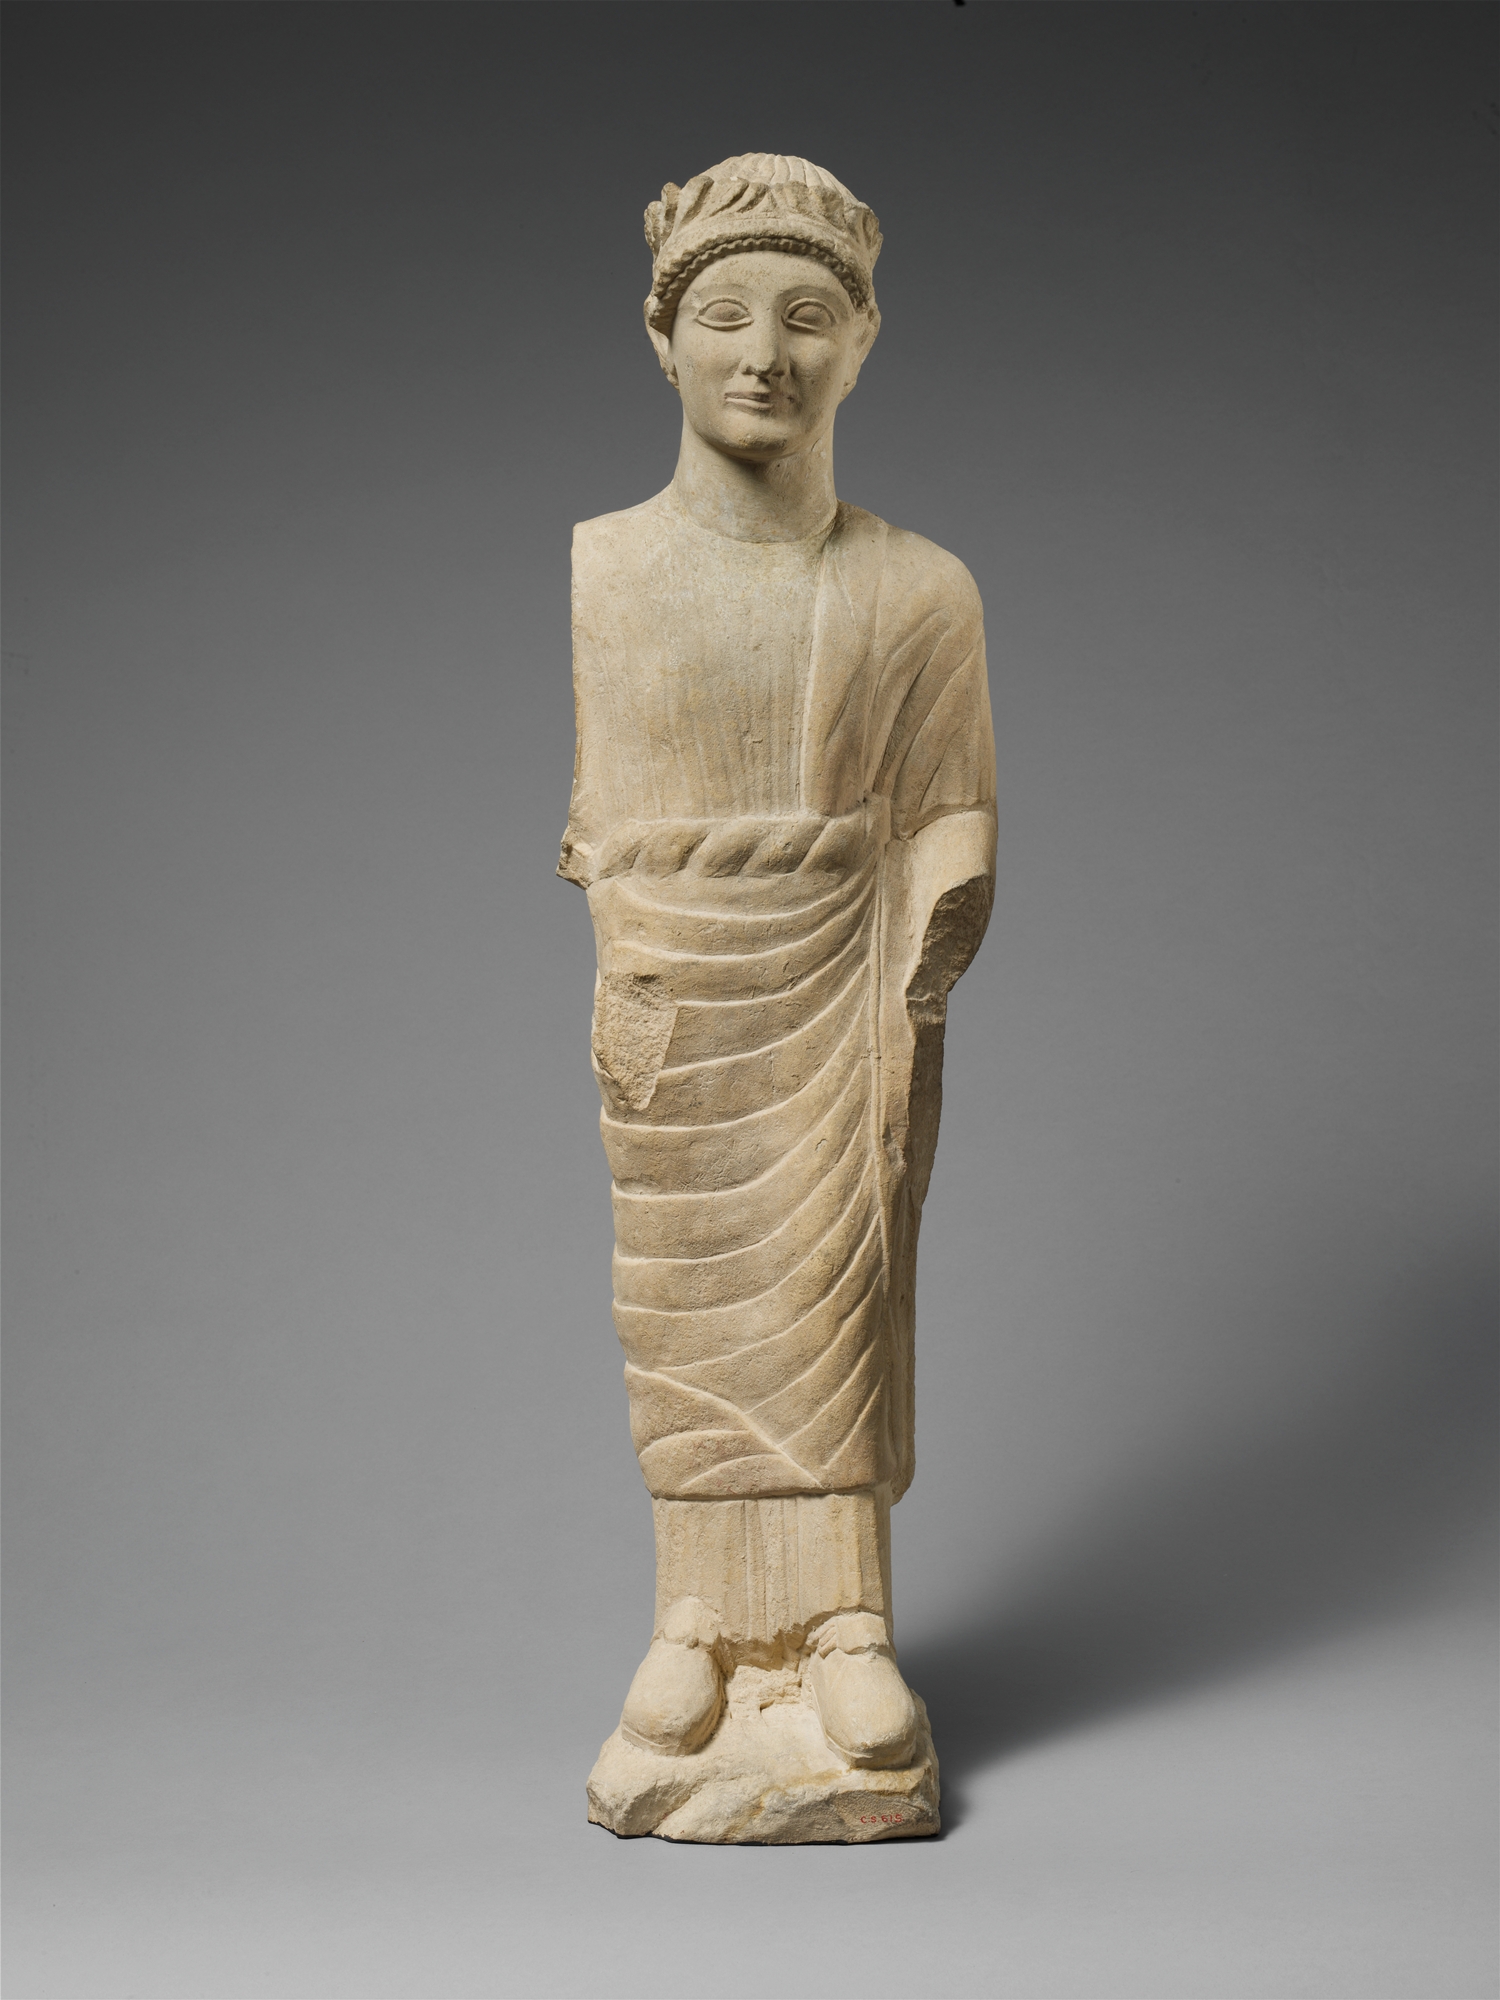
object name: statue of a votary, male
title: Limestone statuette of a beardless male votary with a wreath of leaves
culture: cypriot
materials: limestone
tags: men,leaves,wreaths